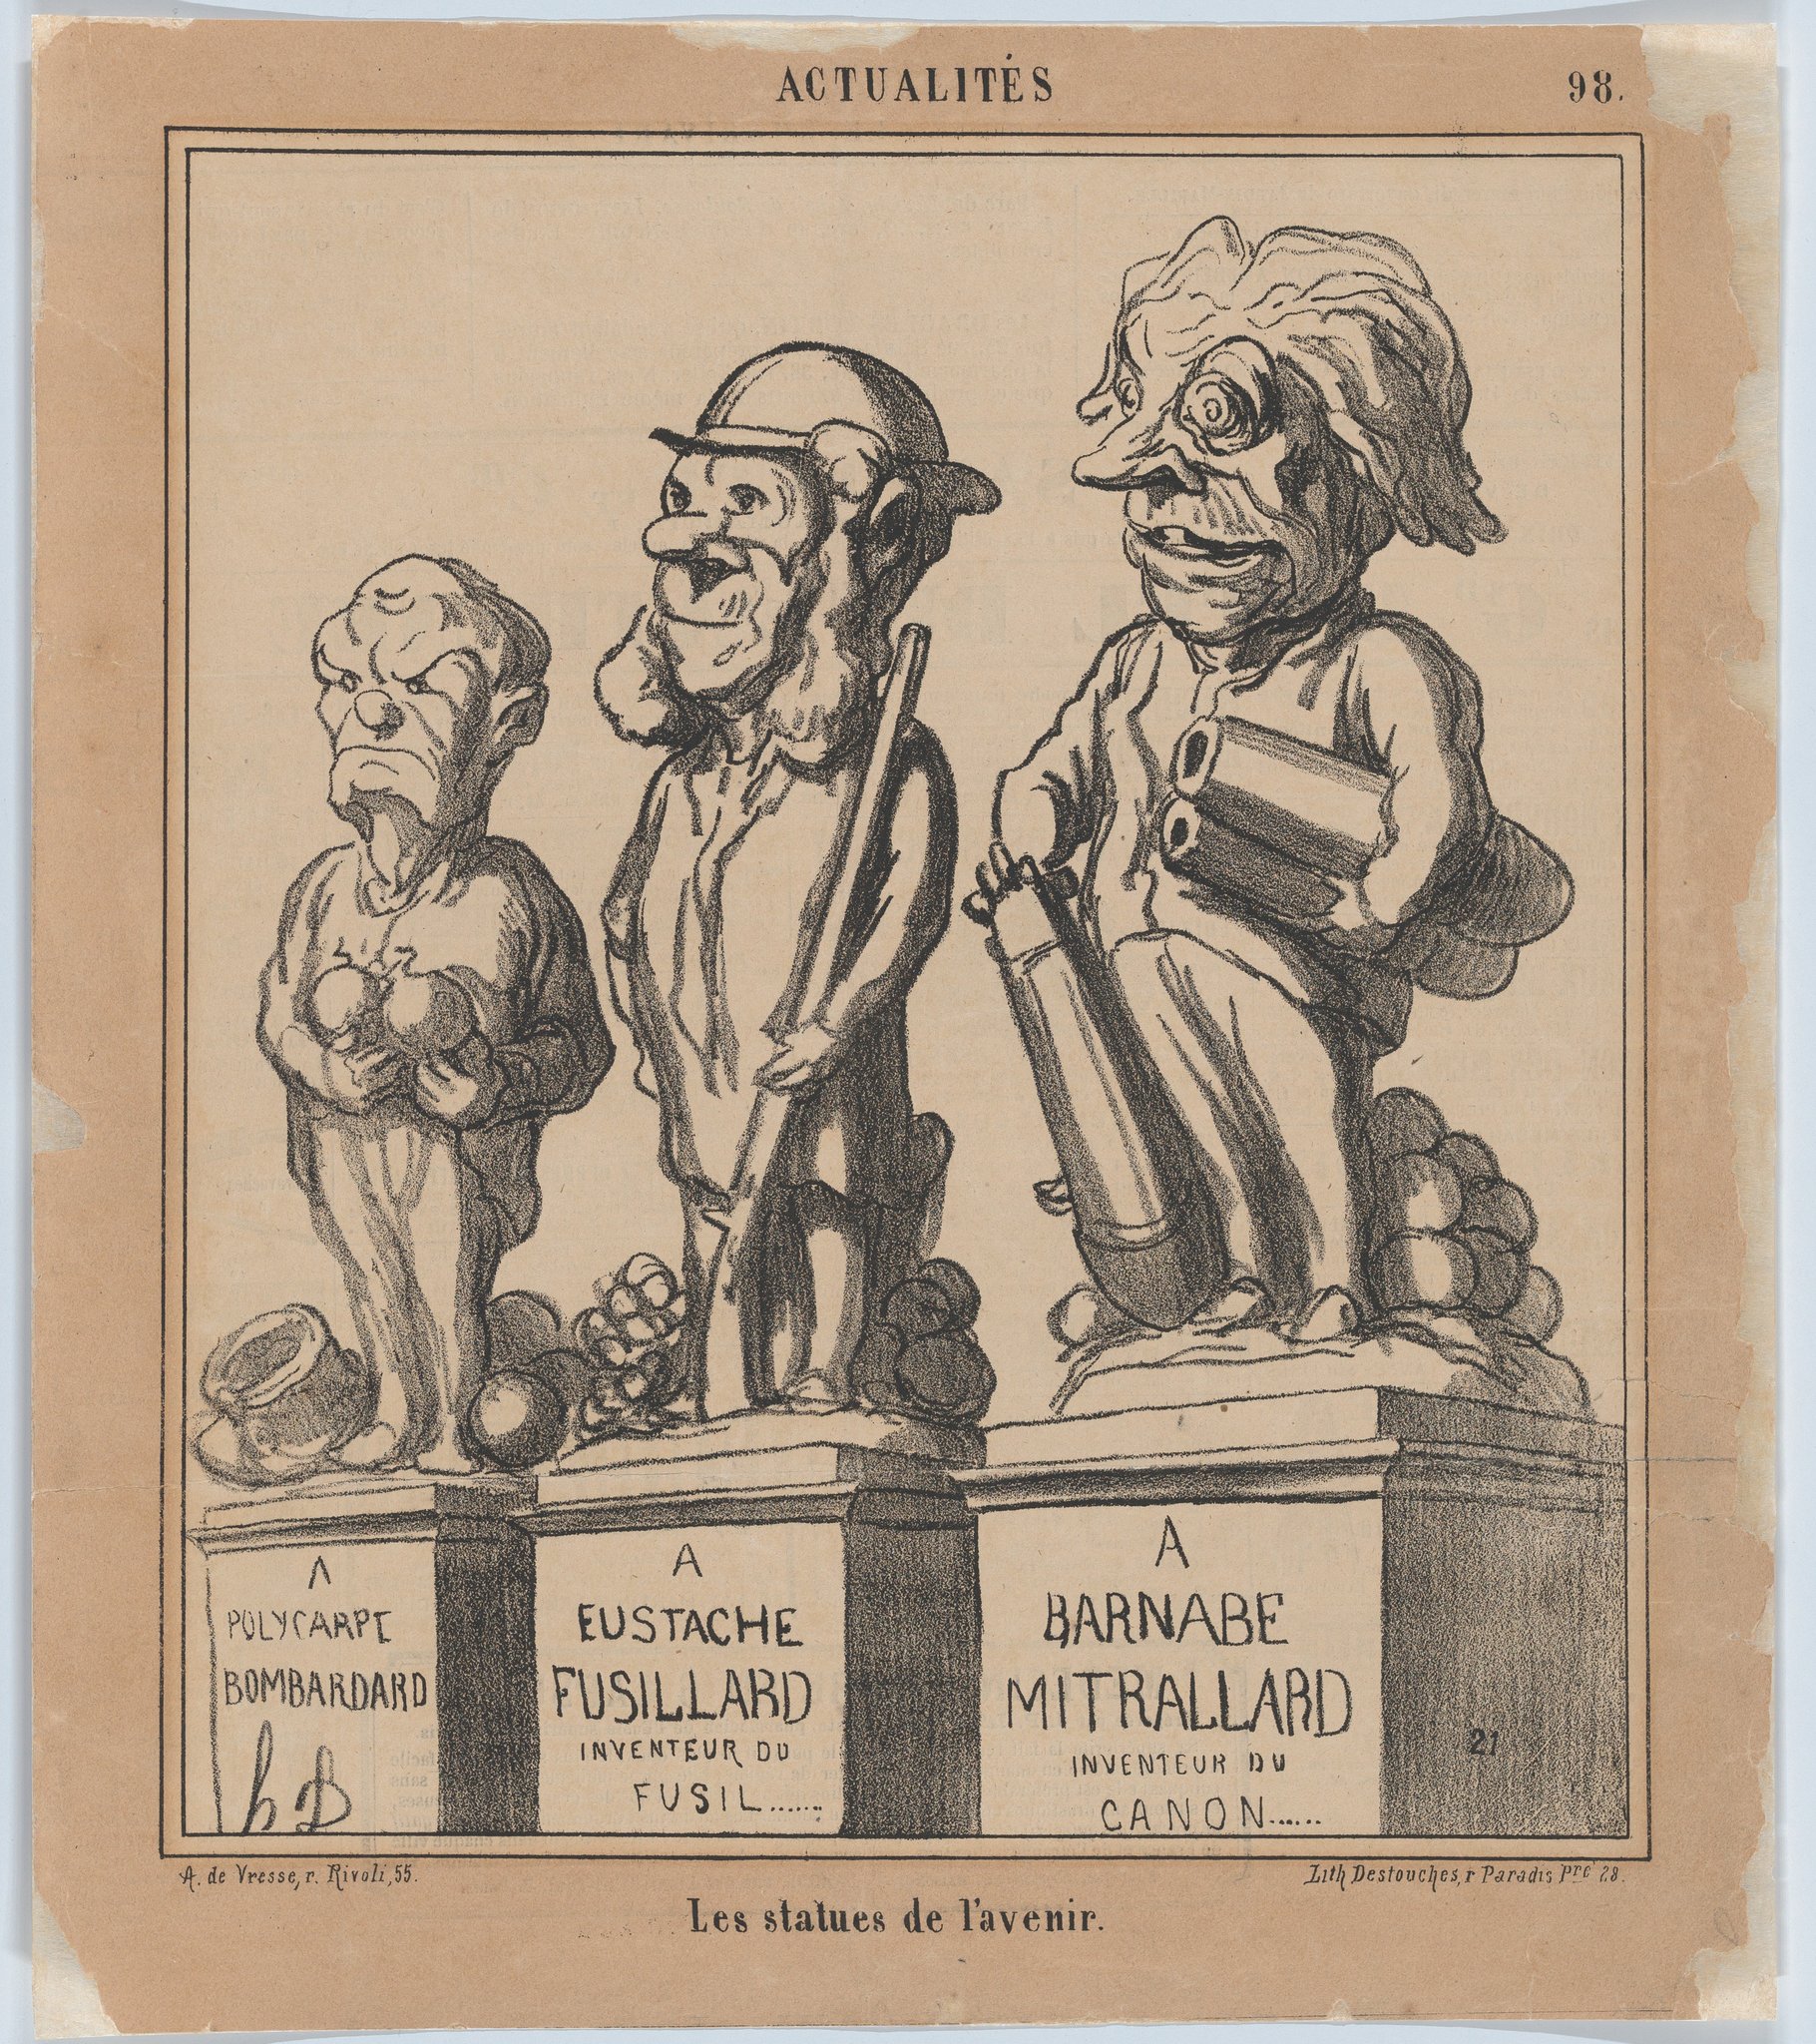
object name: print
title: Statues of the Future, from 'News of the day,' published in Le Charivari, April 29, 1868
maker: honoré daumier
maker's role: artist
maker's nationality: french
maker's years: 1808-1879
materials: paper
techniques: lithograph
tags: human figures